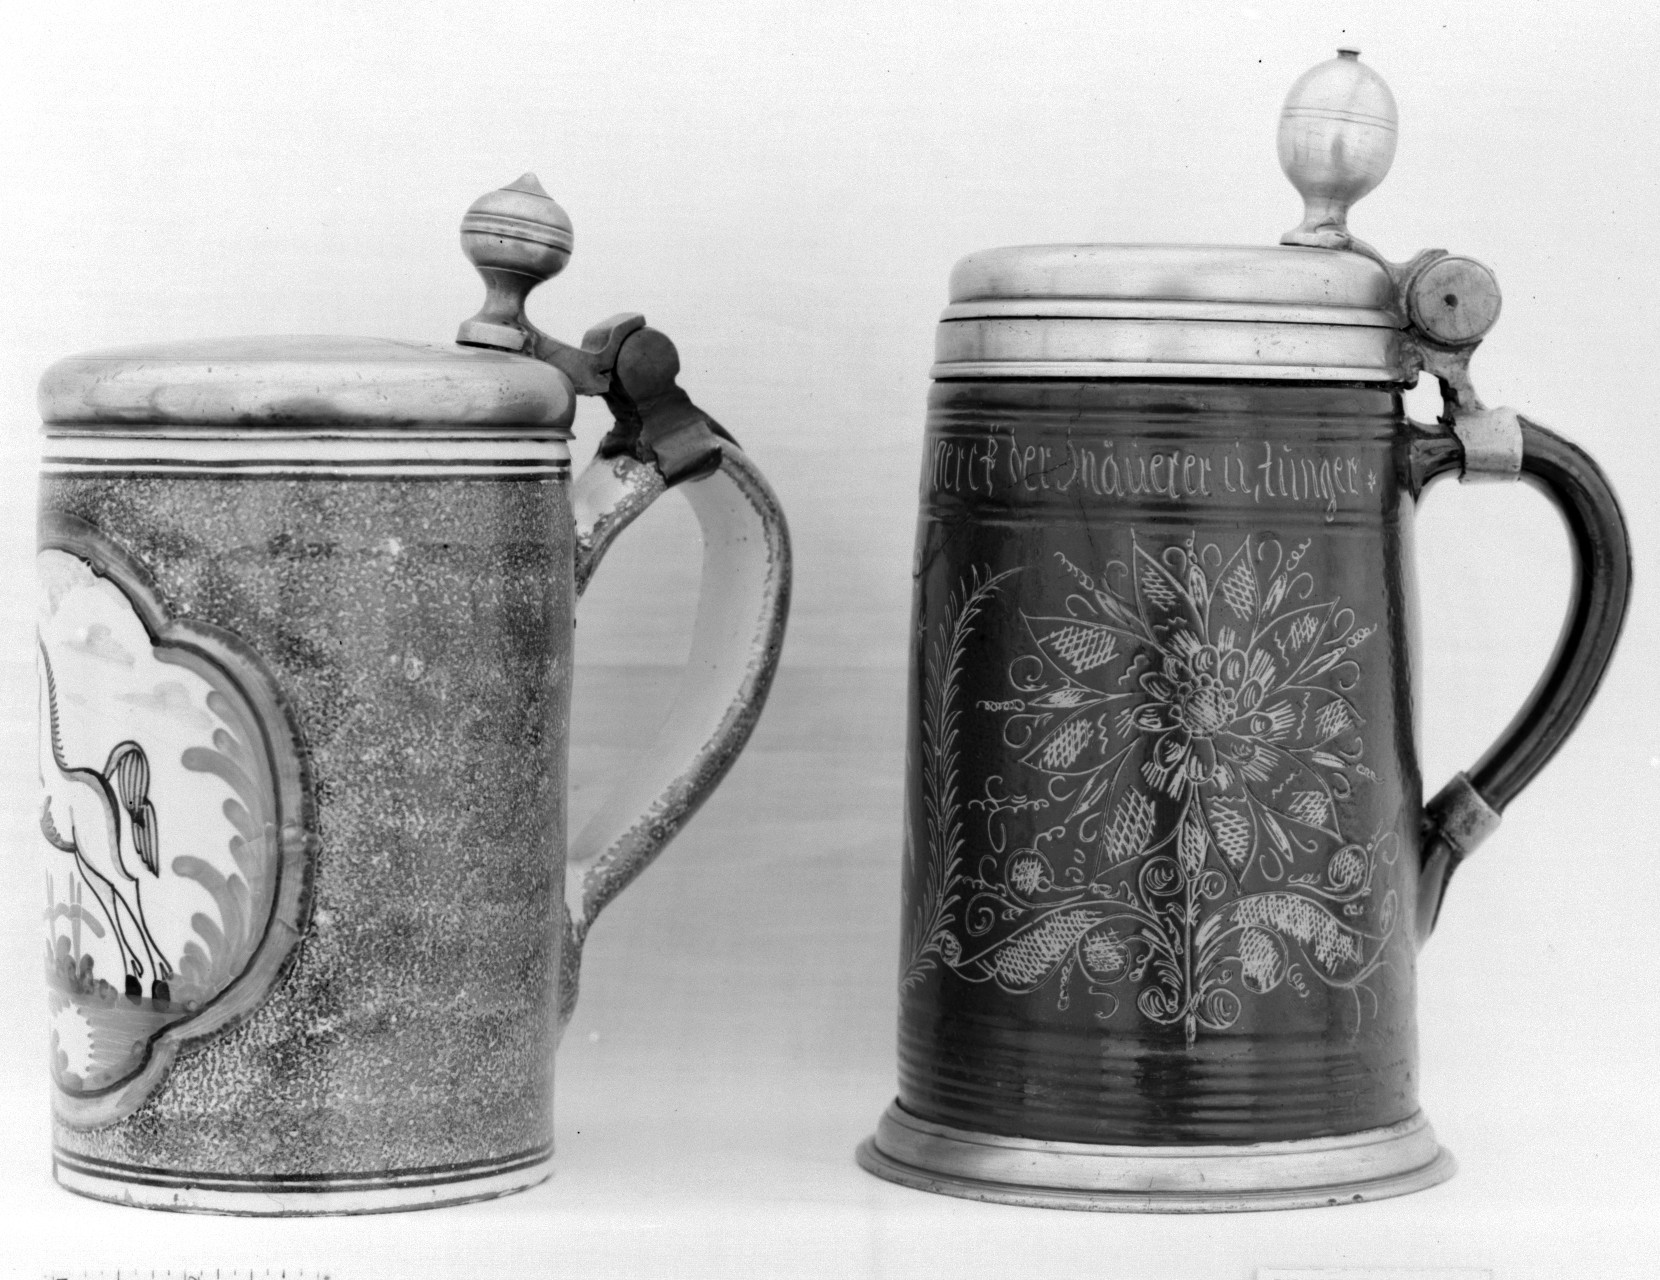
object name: tankard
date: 1701-1800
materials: earthenware, pewter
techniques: glazing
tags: flowers